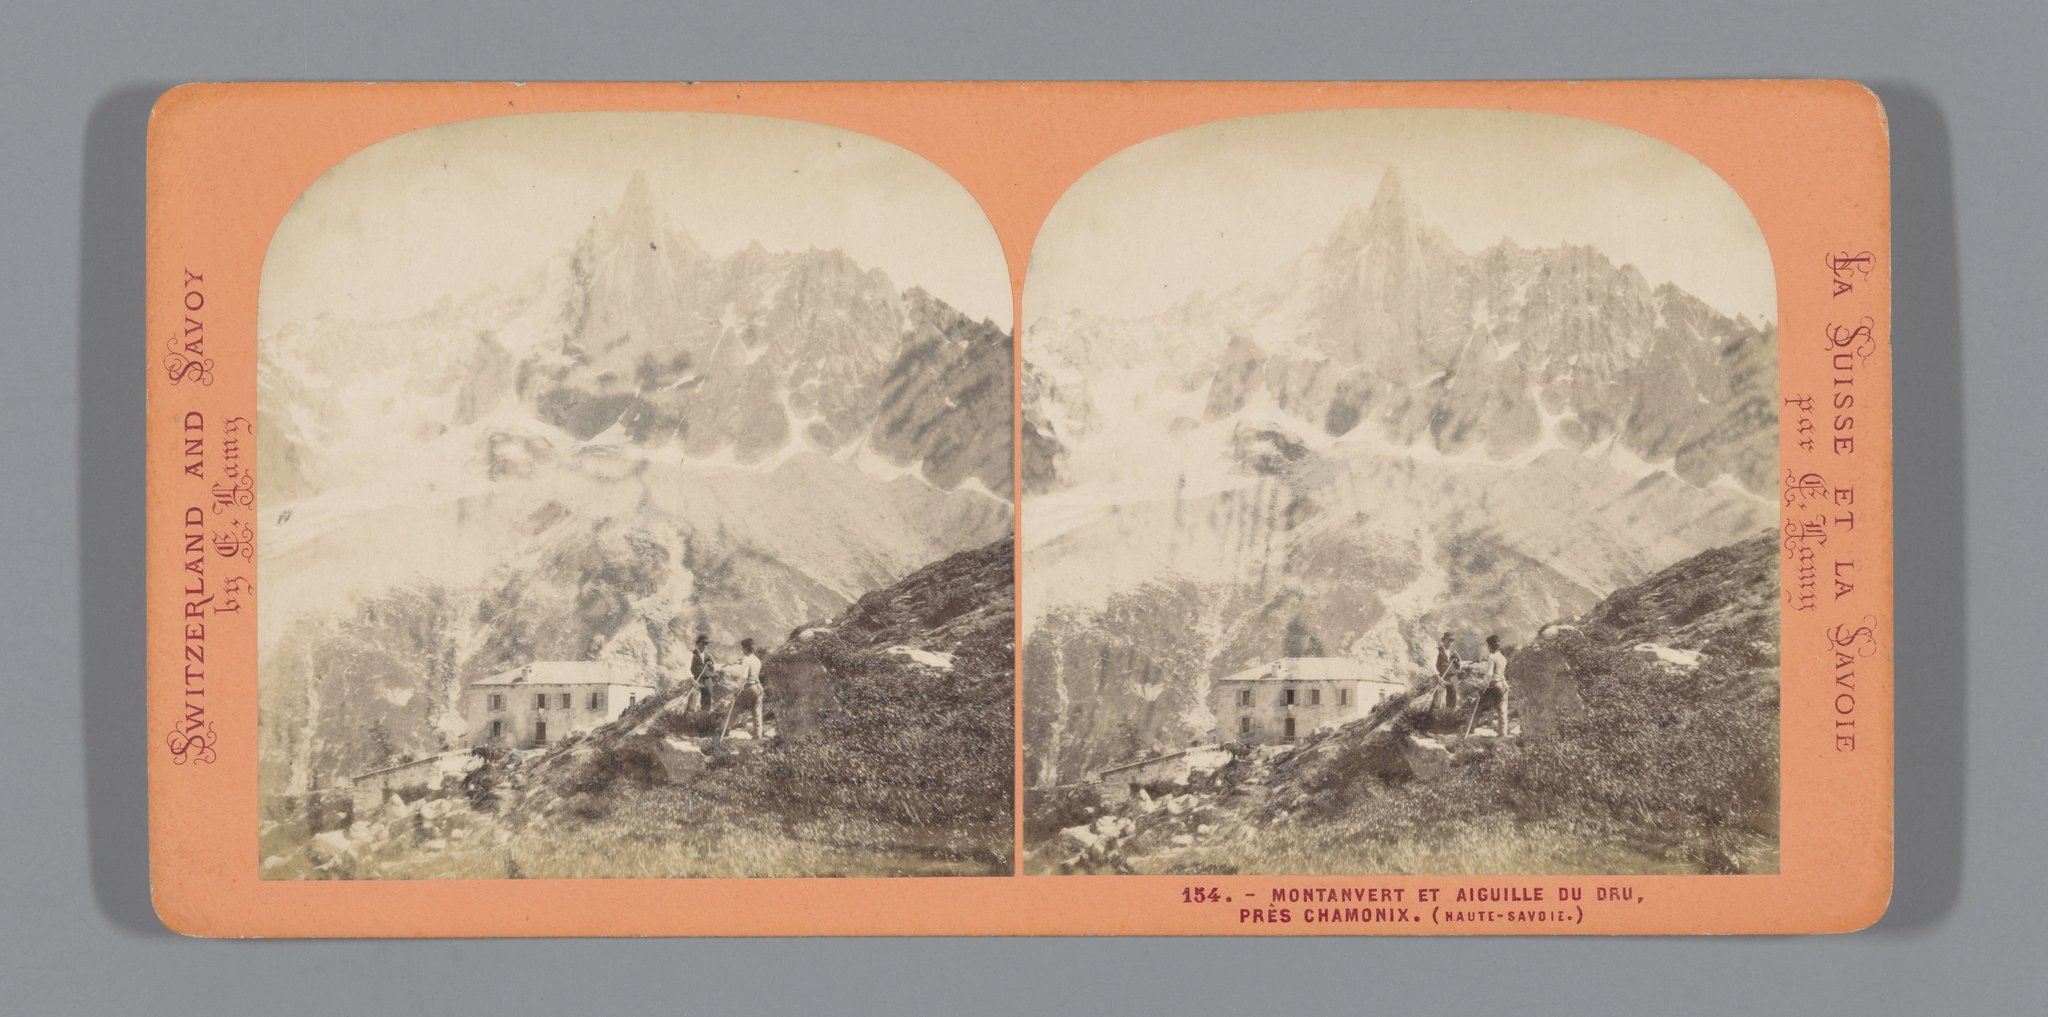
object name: stereograph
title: Montanvert et Aiguille du Dru, près Chamonix. (Haute-Savoie)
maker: ernest eléonor pierre lamy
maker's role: publisher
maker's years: 1828-1900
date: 1860-1880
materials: cardboard, photographic support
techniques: photography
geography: chamonix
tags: mountains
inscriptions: number: ‘154.’